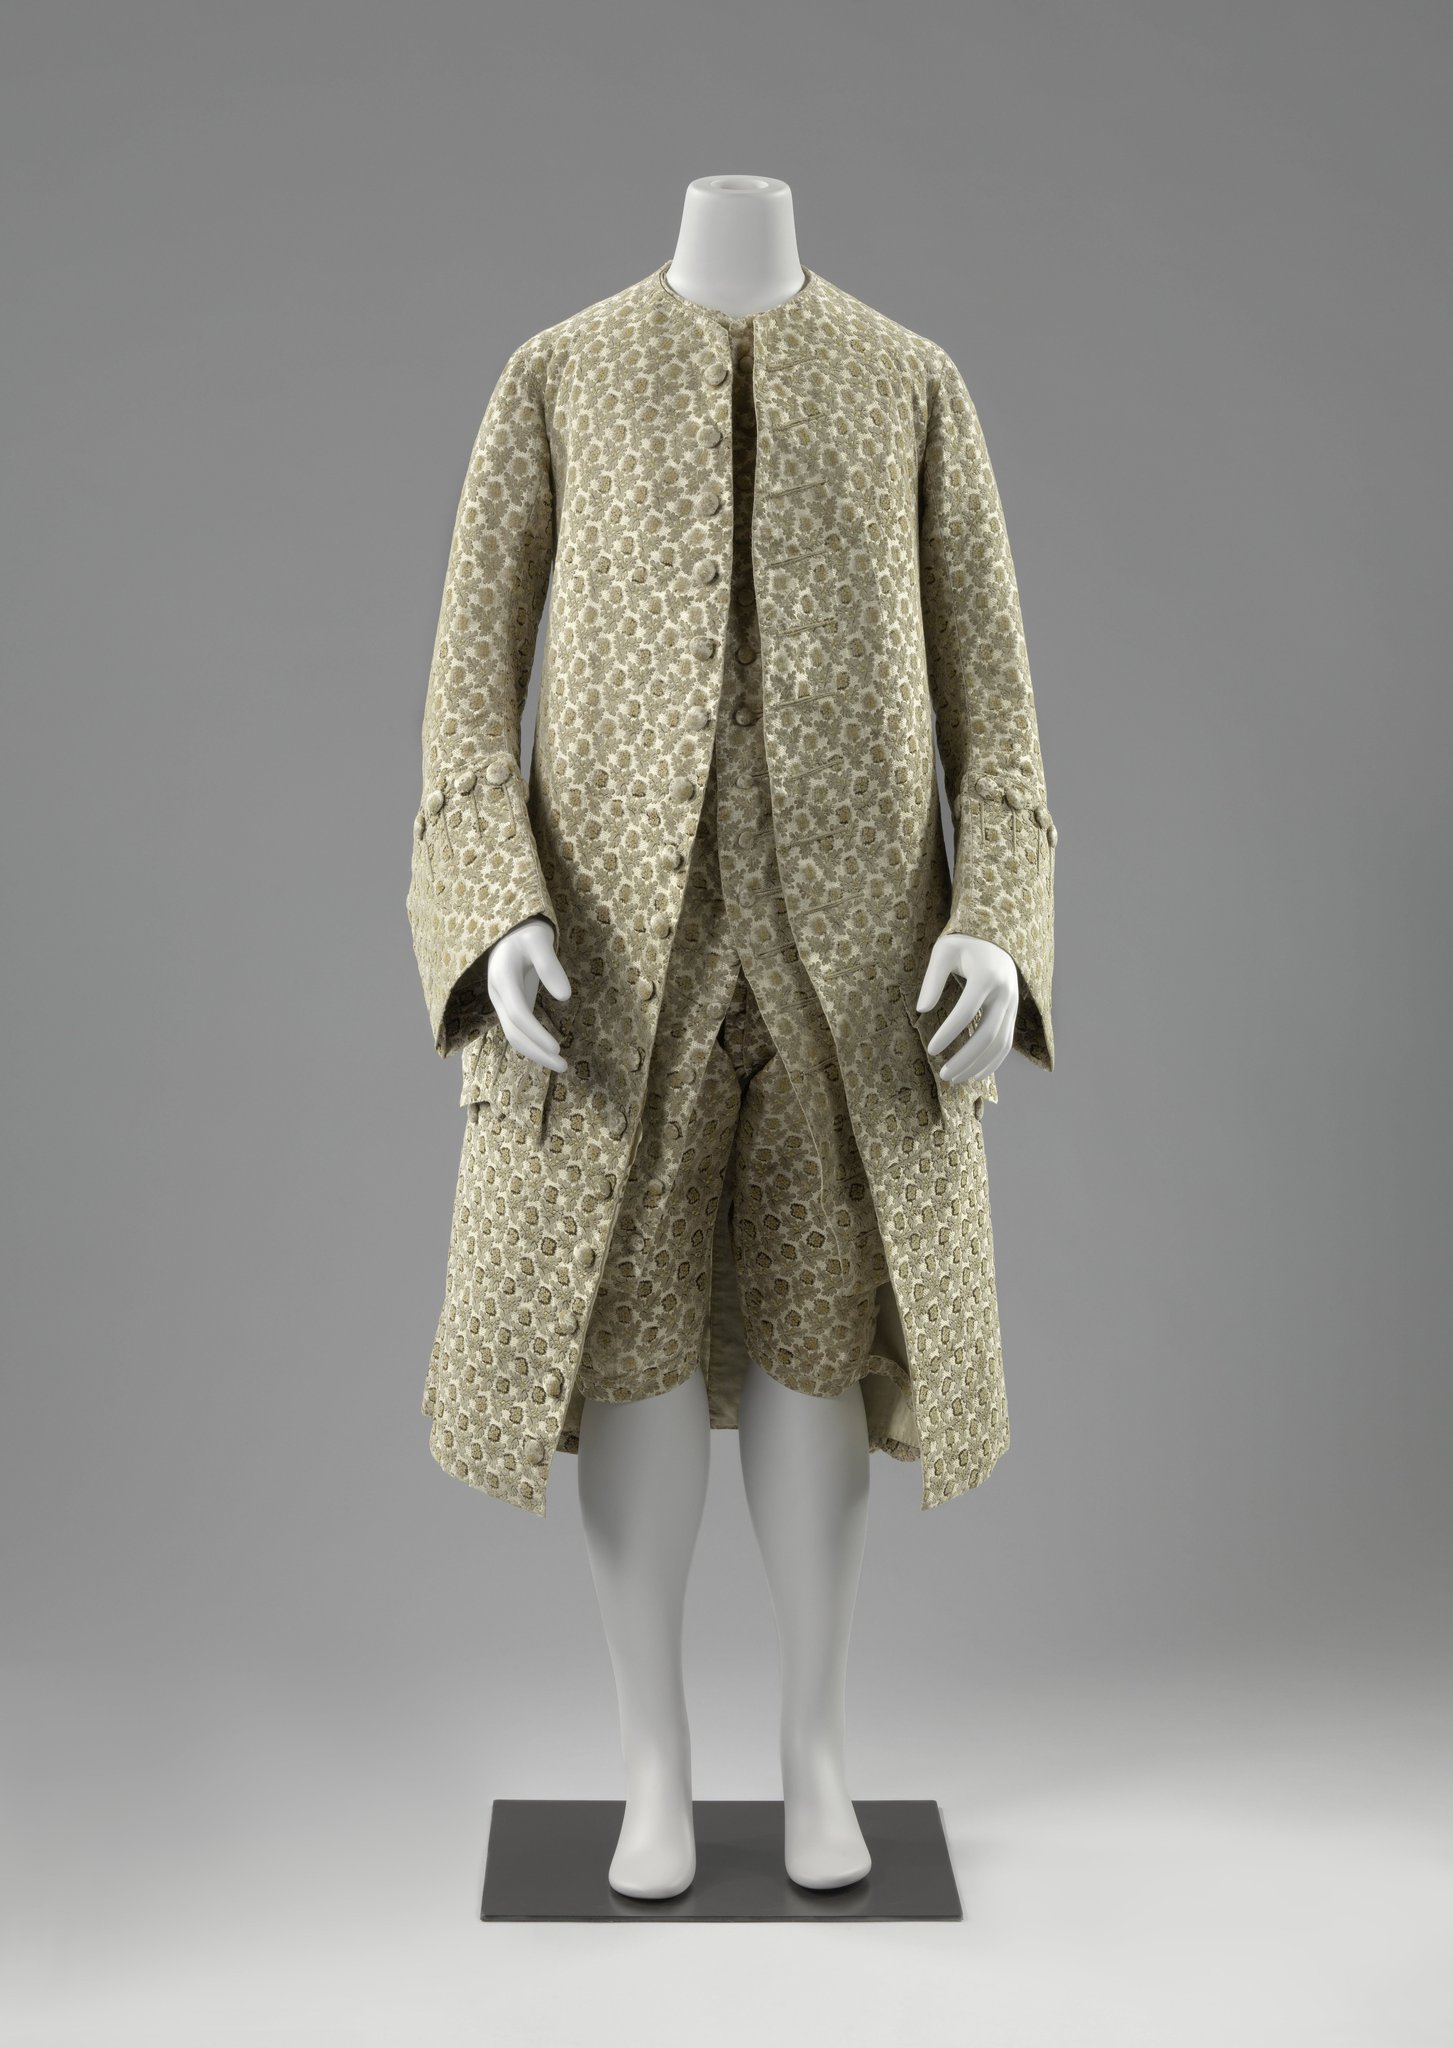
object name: main garment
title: Suit: coat, breaches and waistcoat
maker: Anonymous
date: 1740-1765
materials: silk, wood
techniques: cutting, weave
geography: france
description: The wide cuffs of this frock coat were in vogue in the early half of the 18th century. The faded fabric features a velvet floral pattern woven on a white ground. This material, with its small pattern, was designed for men. Often, as here, a whole suit would be made of the same fabric.